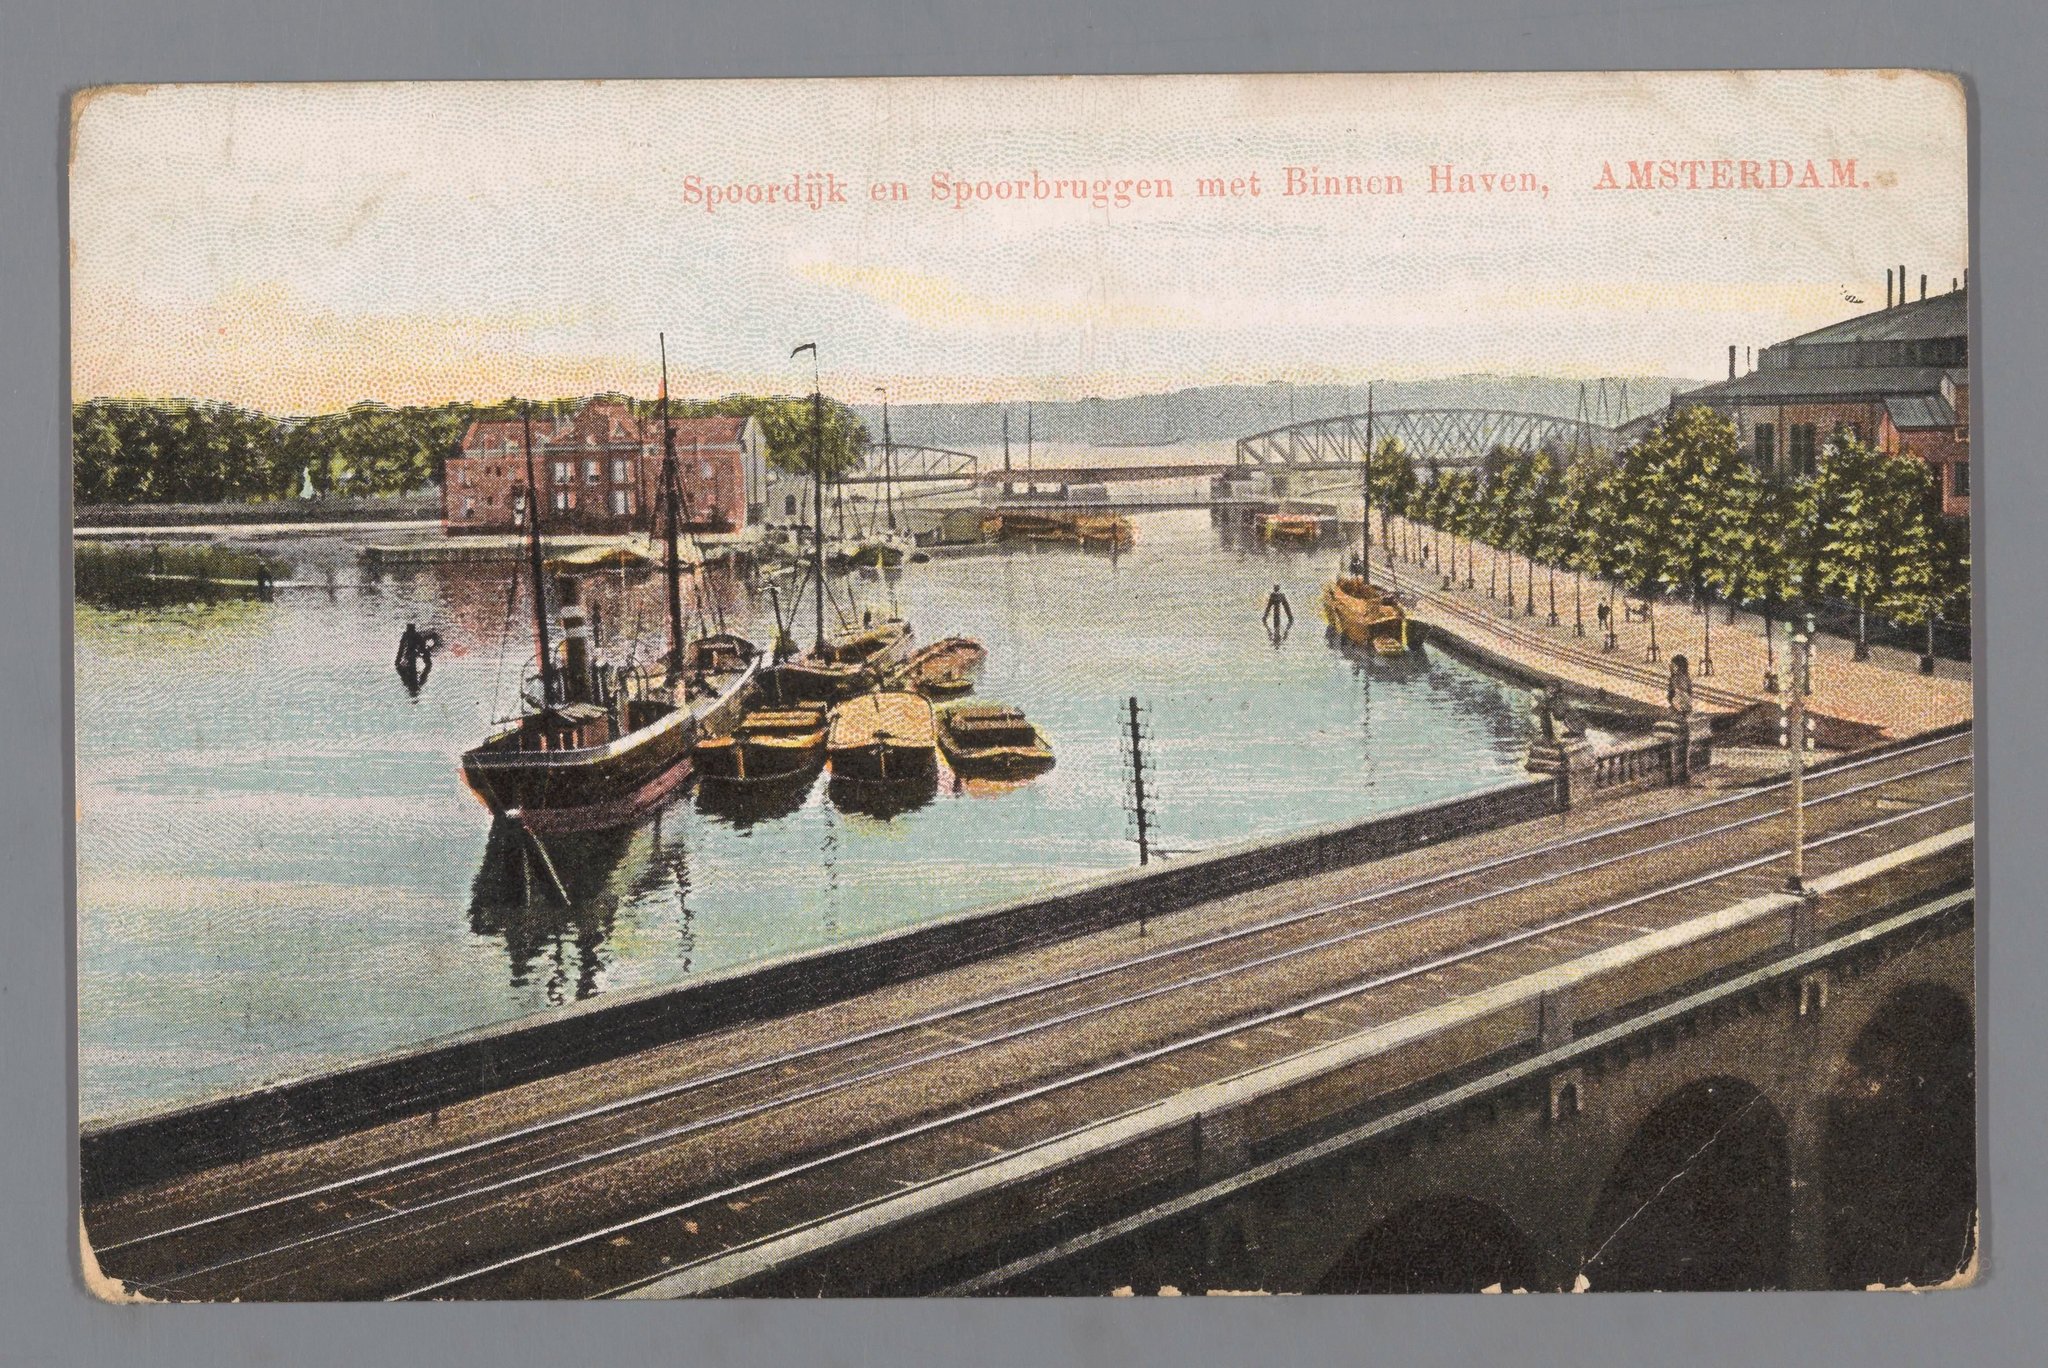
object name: photomechanical print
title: Spoordijk en Spoorbruggen met Binnen Haven, Amsterdam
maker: Anonymous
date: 1880-1920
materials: cardboard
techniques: four-color autotype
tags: harbour, railway, tramway; rack railway, amsterdam